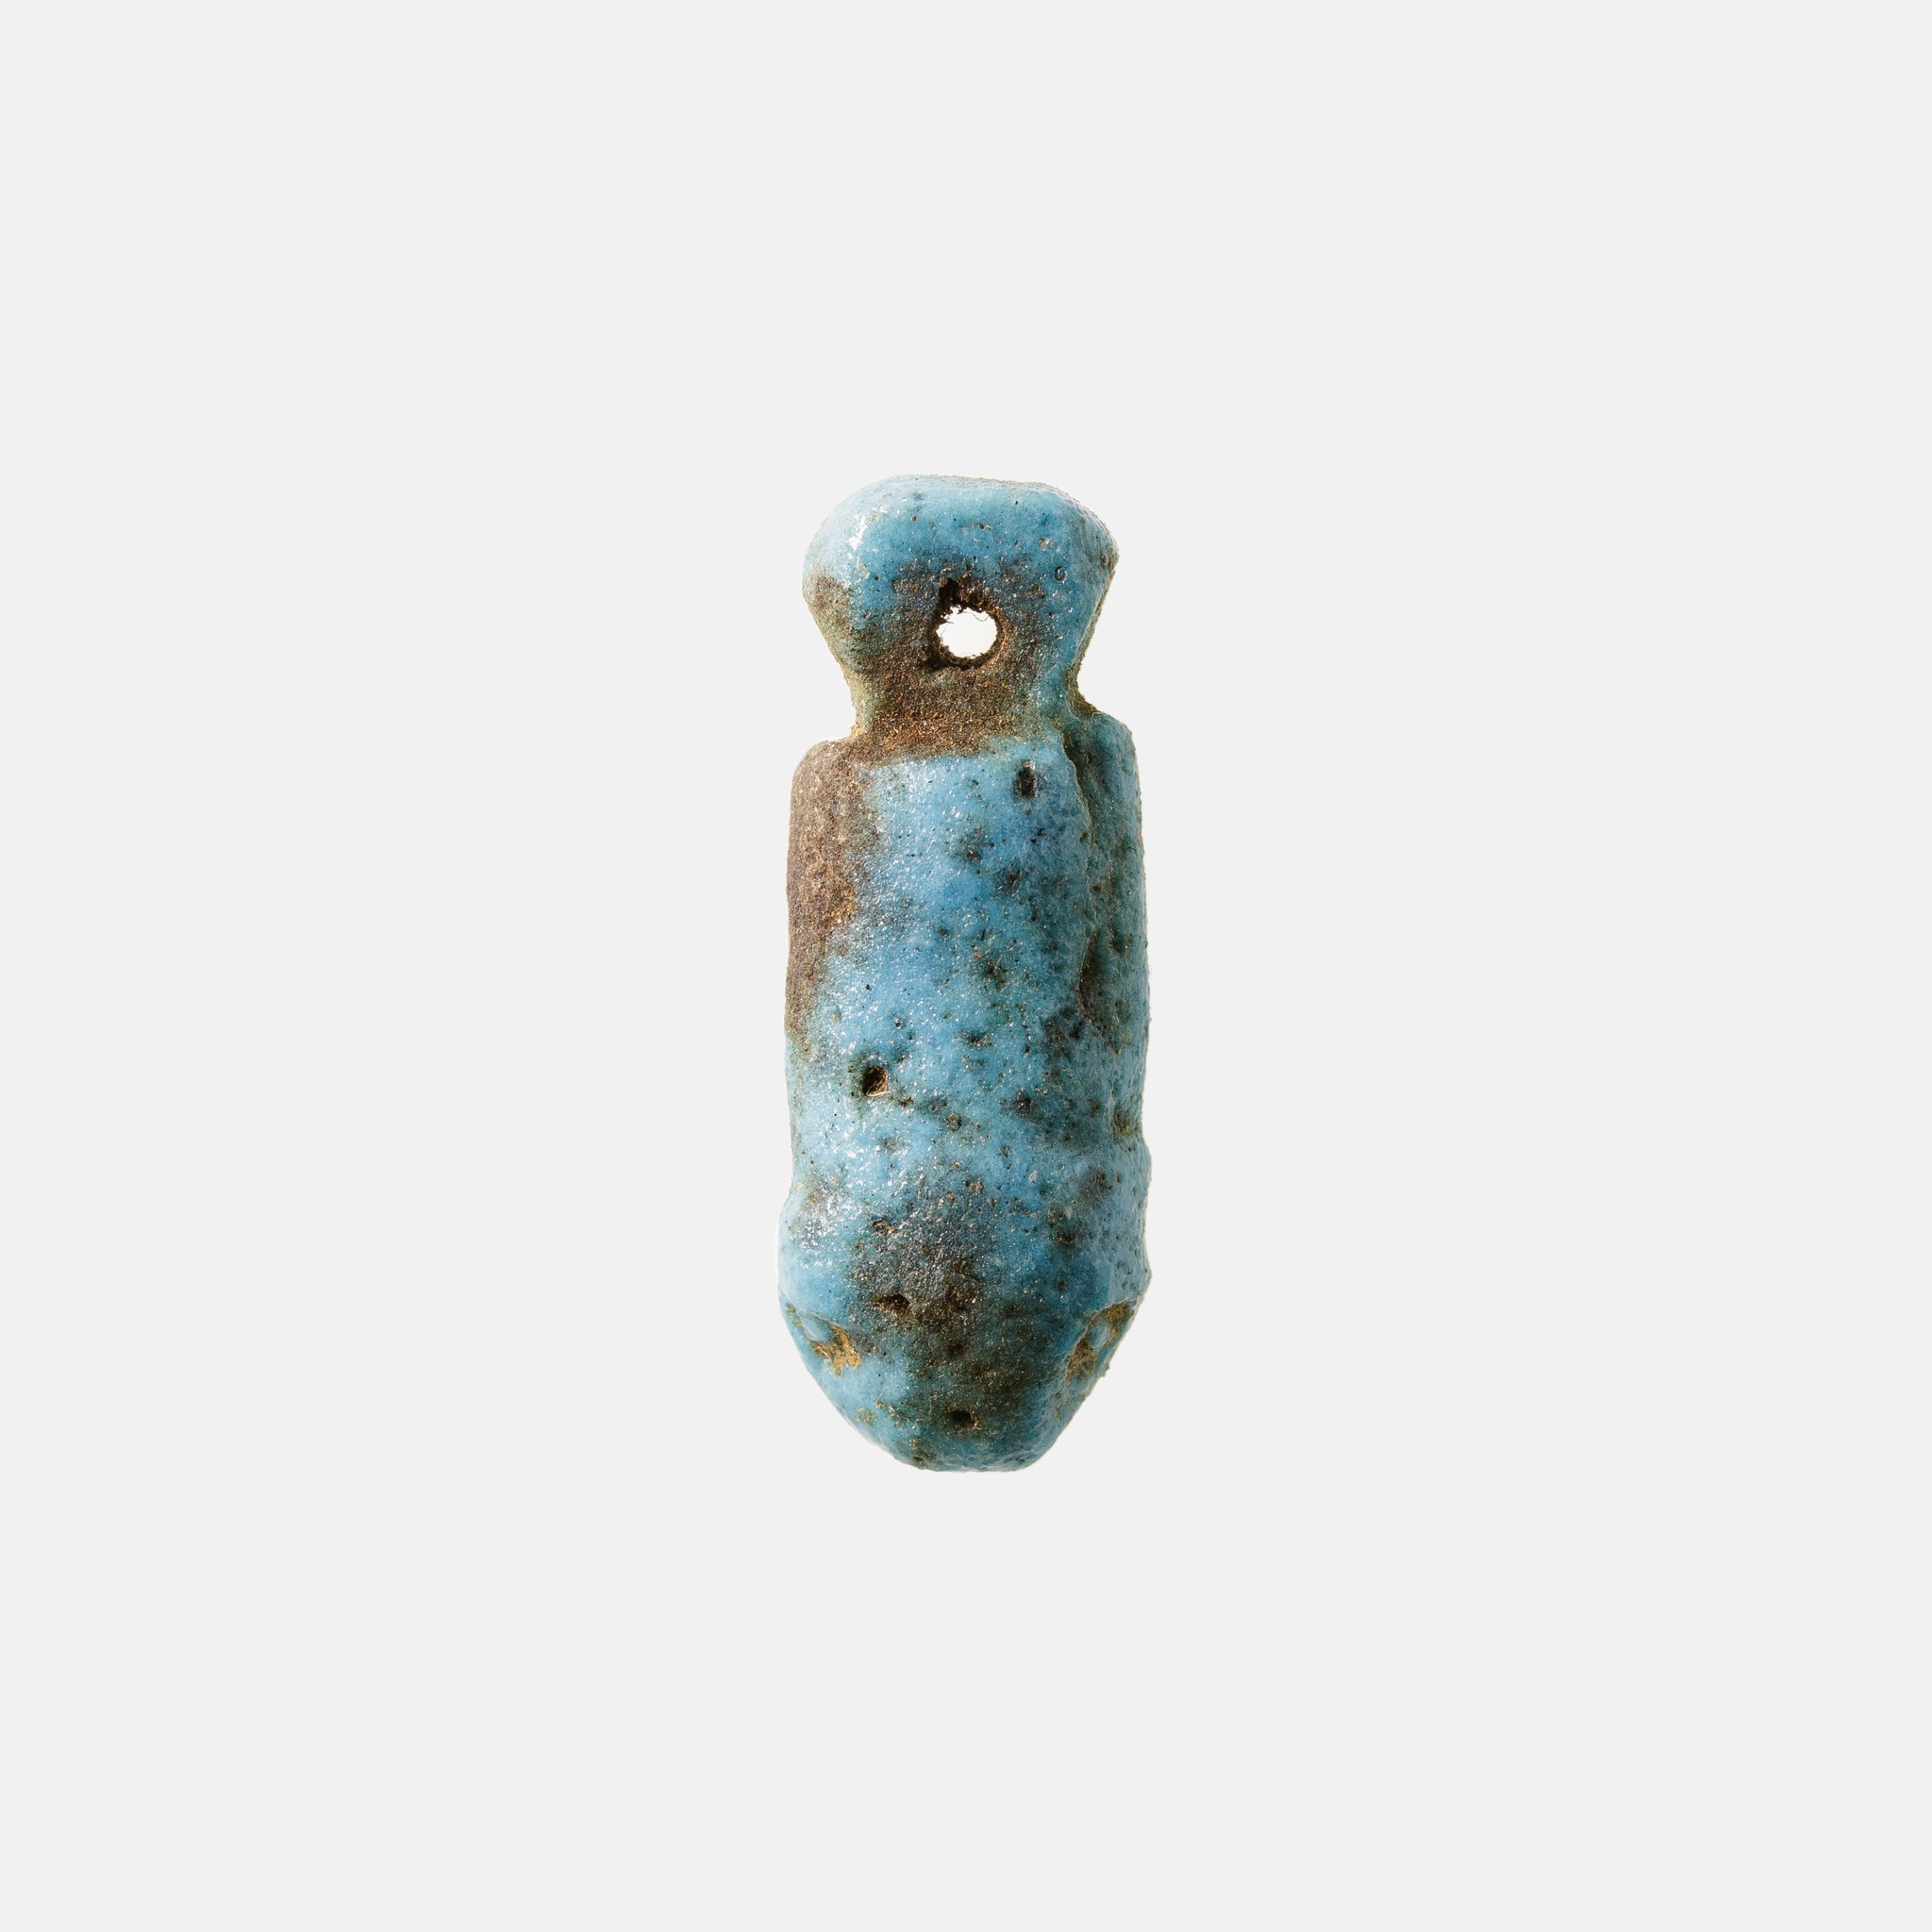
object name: amulet, snake headed staff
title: Snake head amulet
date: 712-332 BCE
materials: faience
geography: egypt